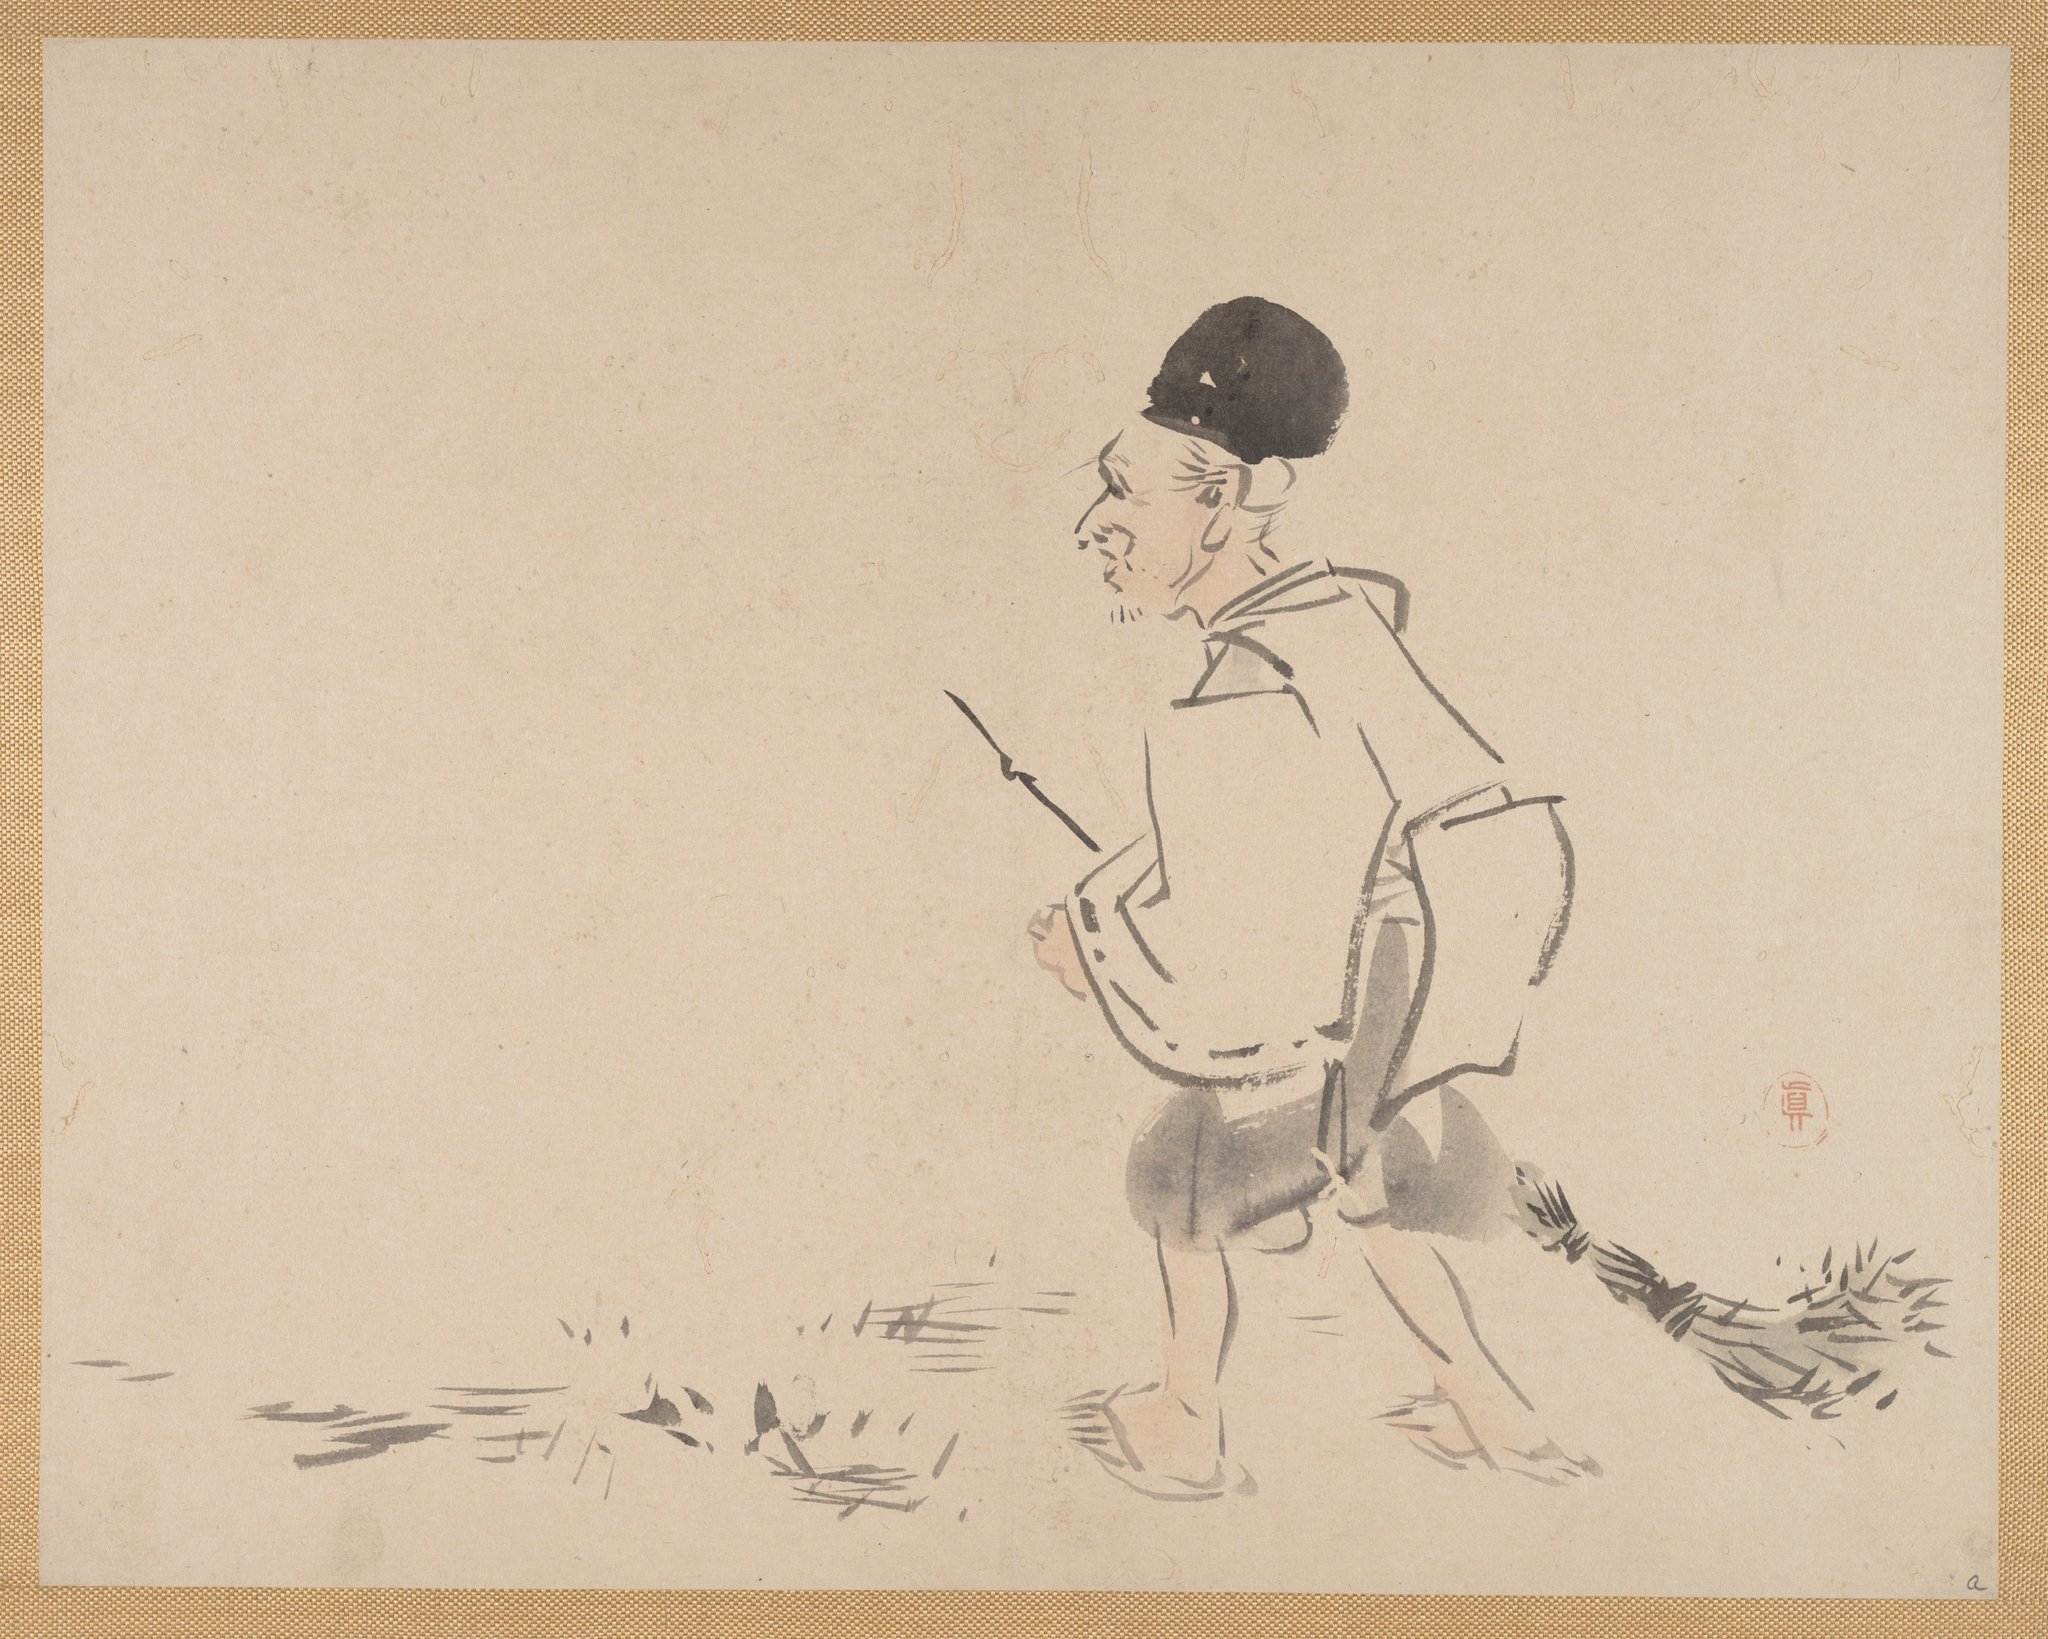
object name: album leaf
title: Painting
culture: japanese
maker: shibata zeshin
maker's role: artist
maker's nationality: japanese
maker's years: 1807-1891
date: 1801-1900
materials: paper, silk, watercolor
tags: men